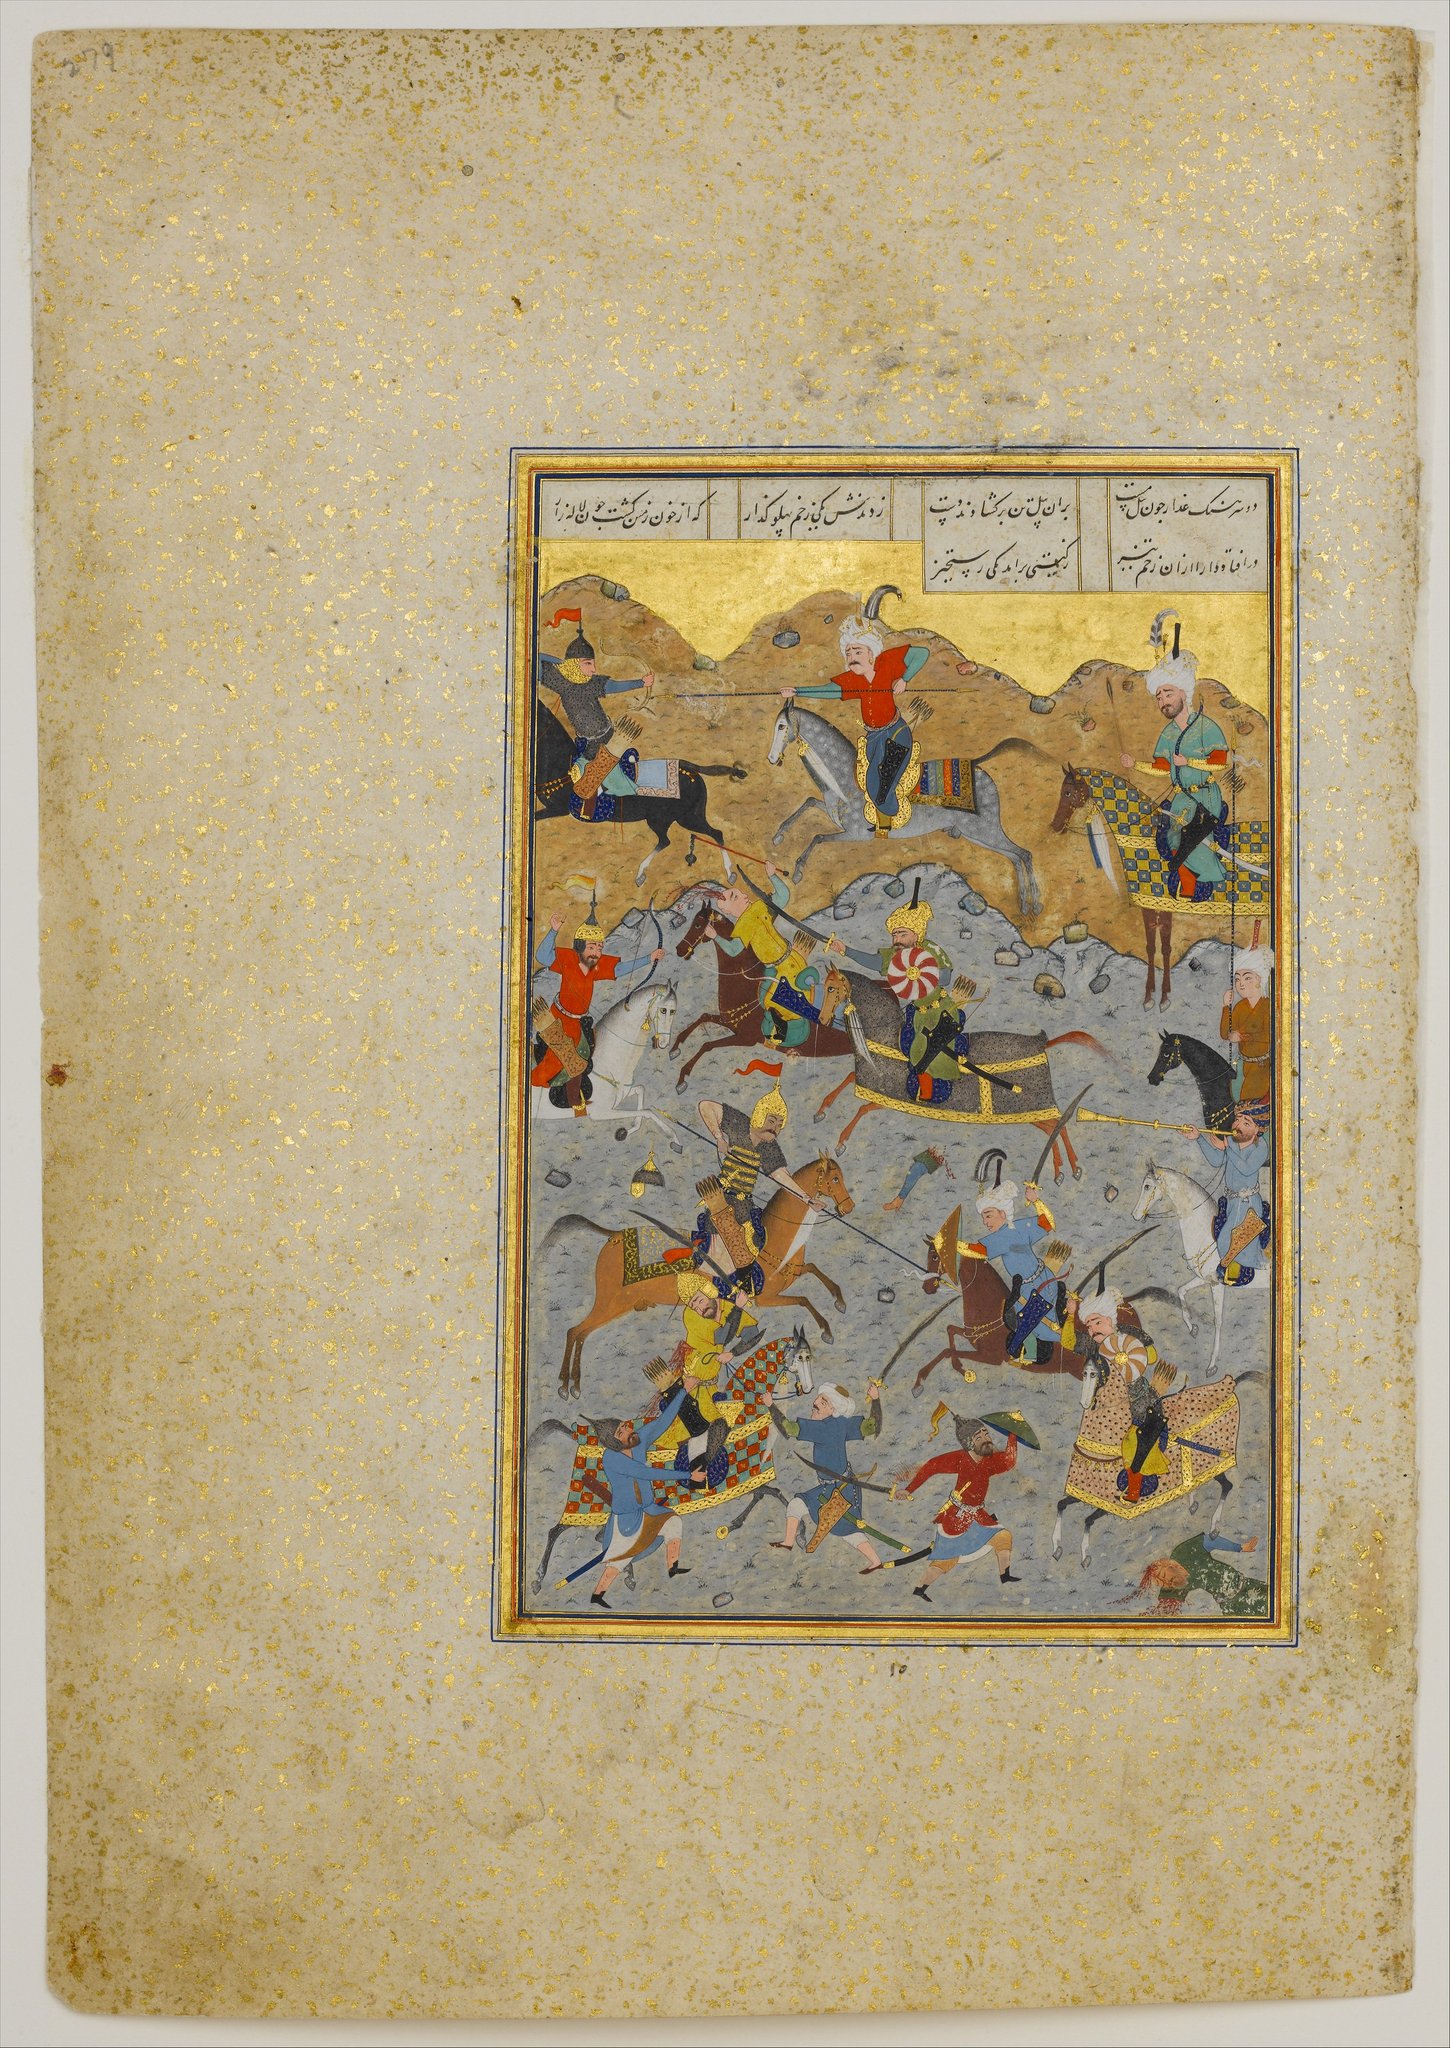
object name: folio from an illustrated manuscript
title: "Battle between Alexander and Darius", Folio 279 from a Khamsa (Quintet) of Nizami of Ganja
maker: nizami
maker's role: author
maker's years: 1141-1209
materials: gold, ink, paper, watercolor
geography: afghanistan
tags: battles,men,horses